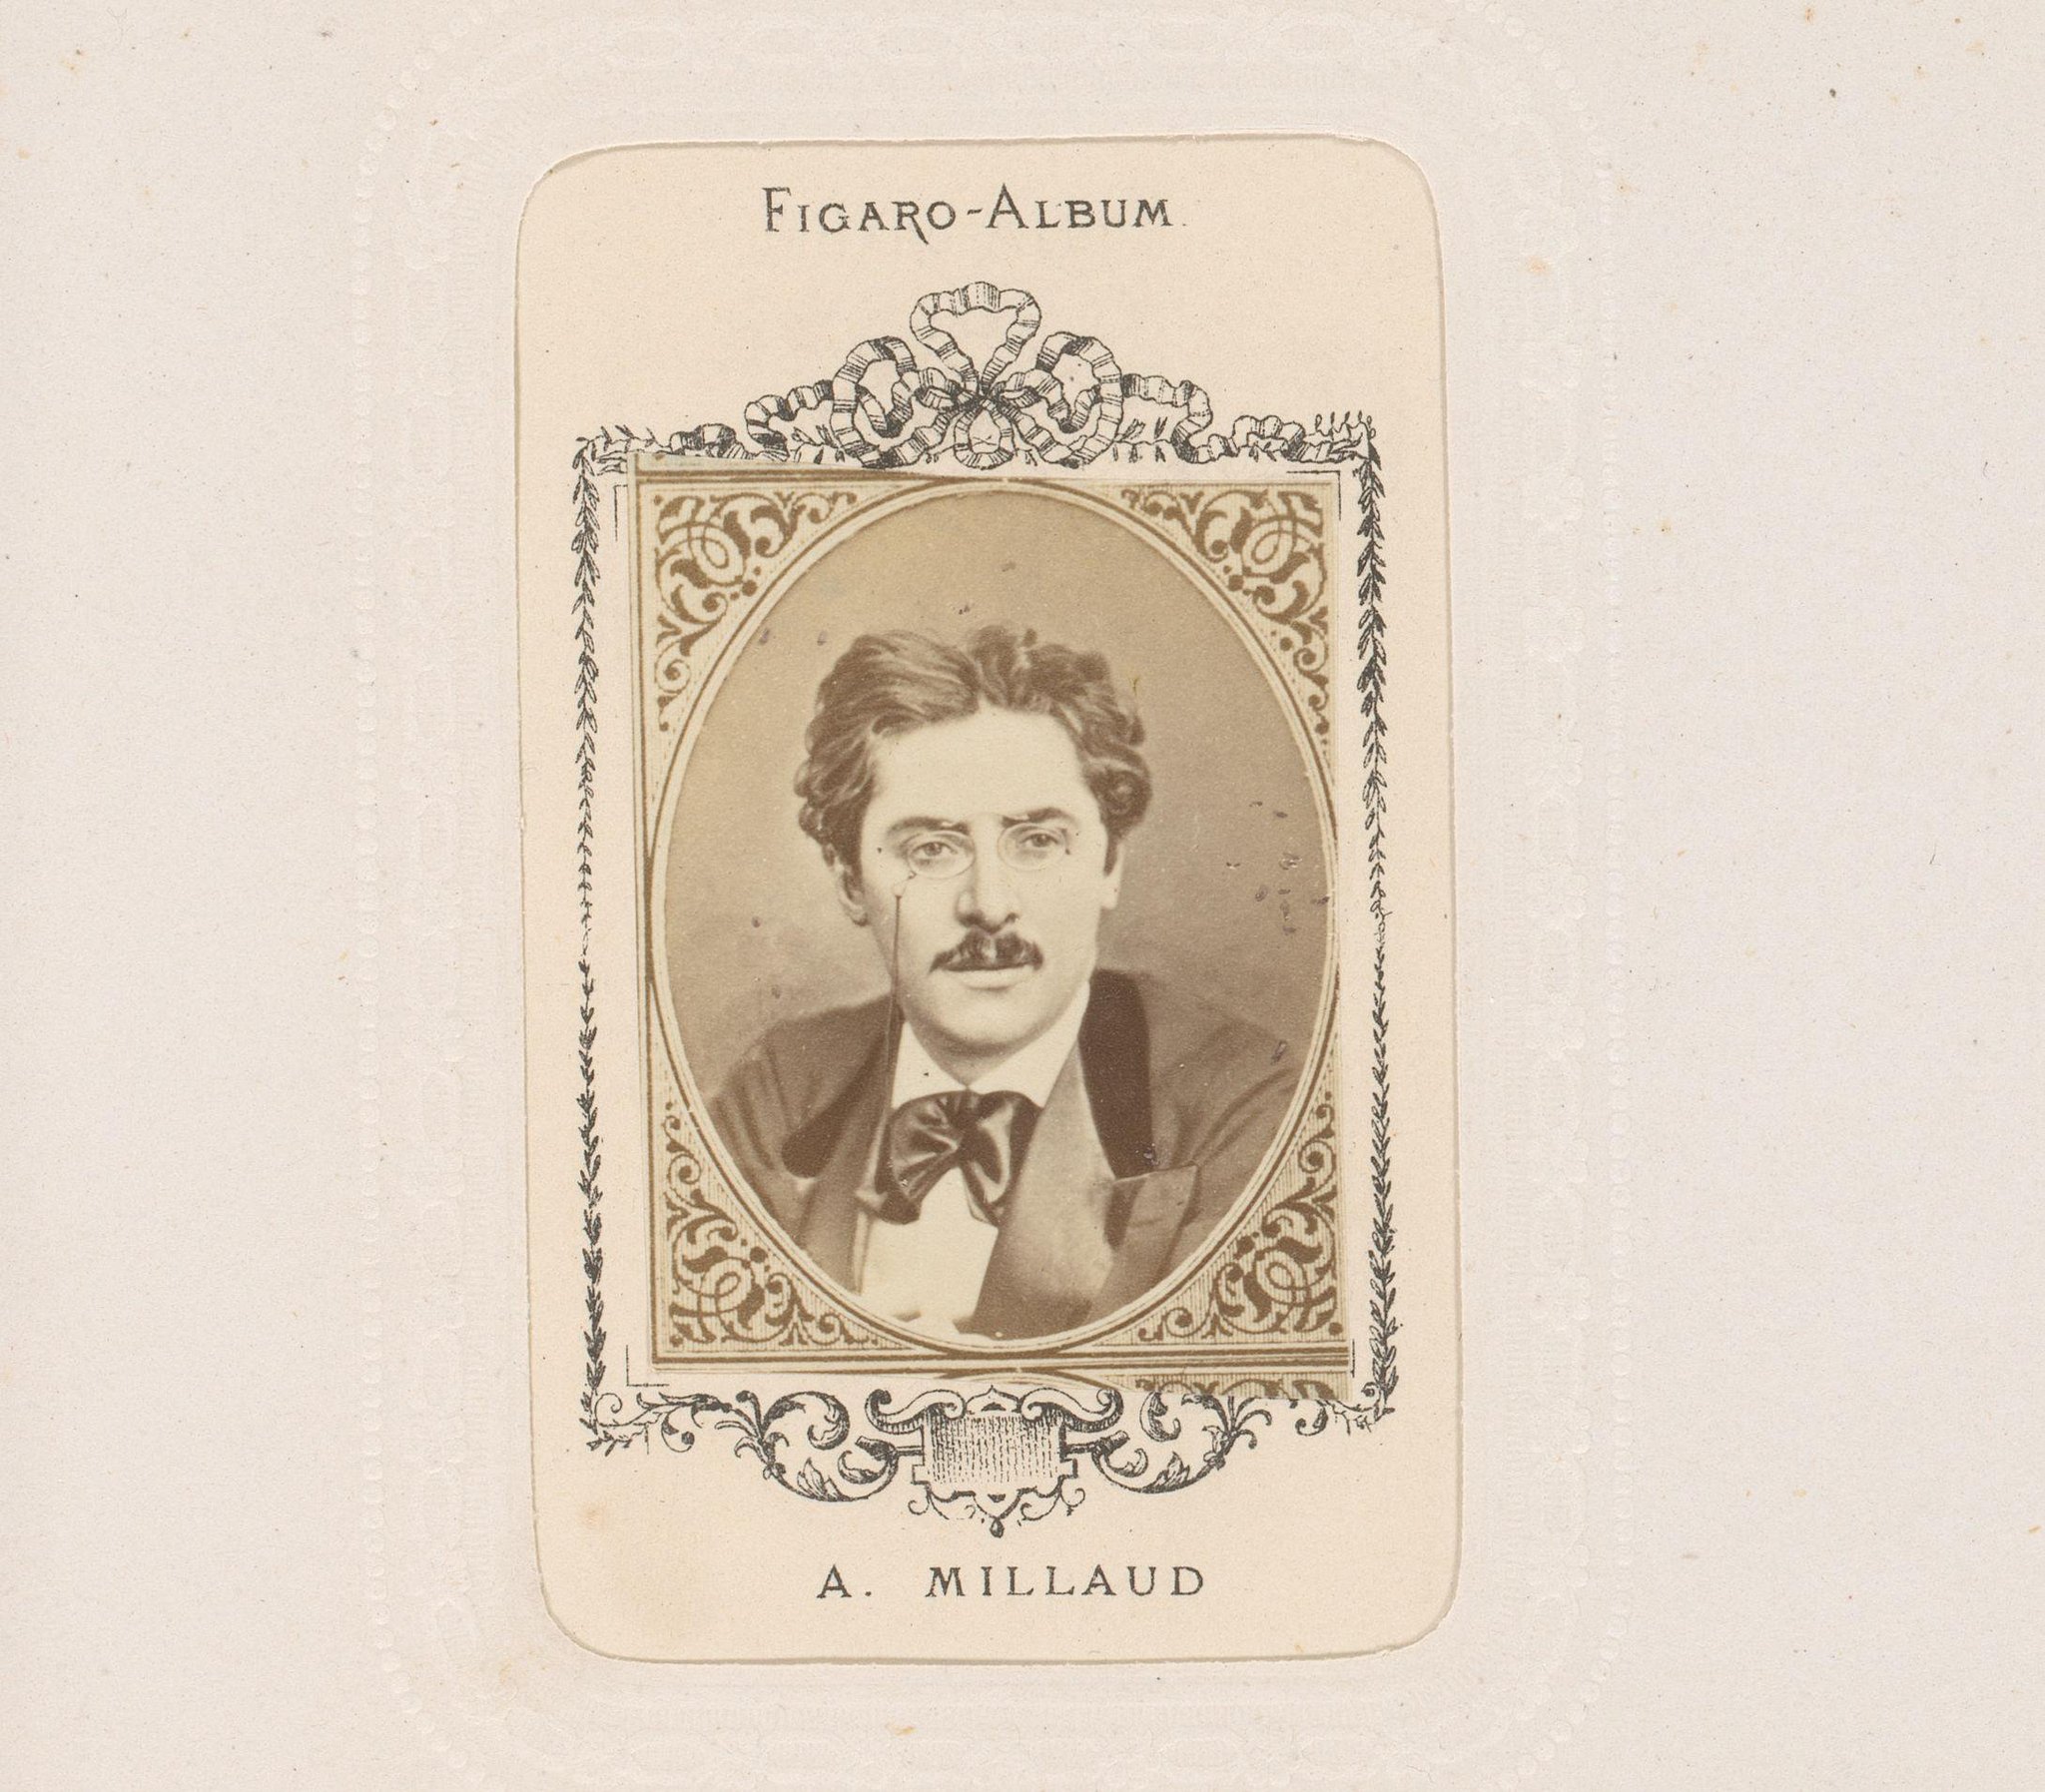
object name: album leaf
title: Fotoreproductie van een portret van Albert Millaud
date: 1860-1900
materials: cardboard, photographic support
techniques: albumen print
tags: paris, journalist, reporter, historical persons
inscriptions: inscription: ‘Figaro-Album/ A. Millaud/ Liébert Phot.’